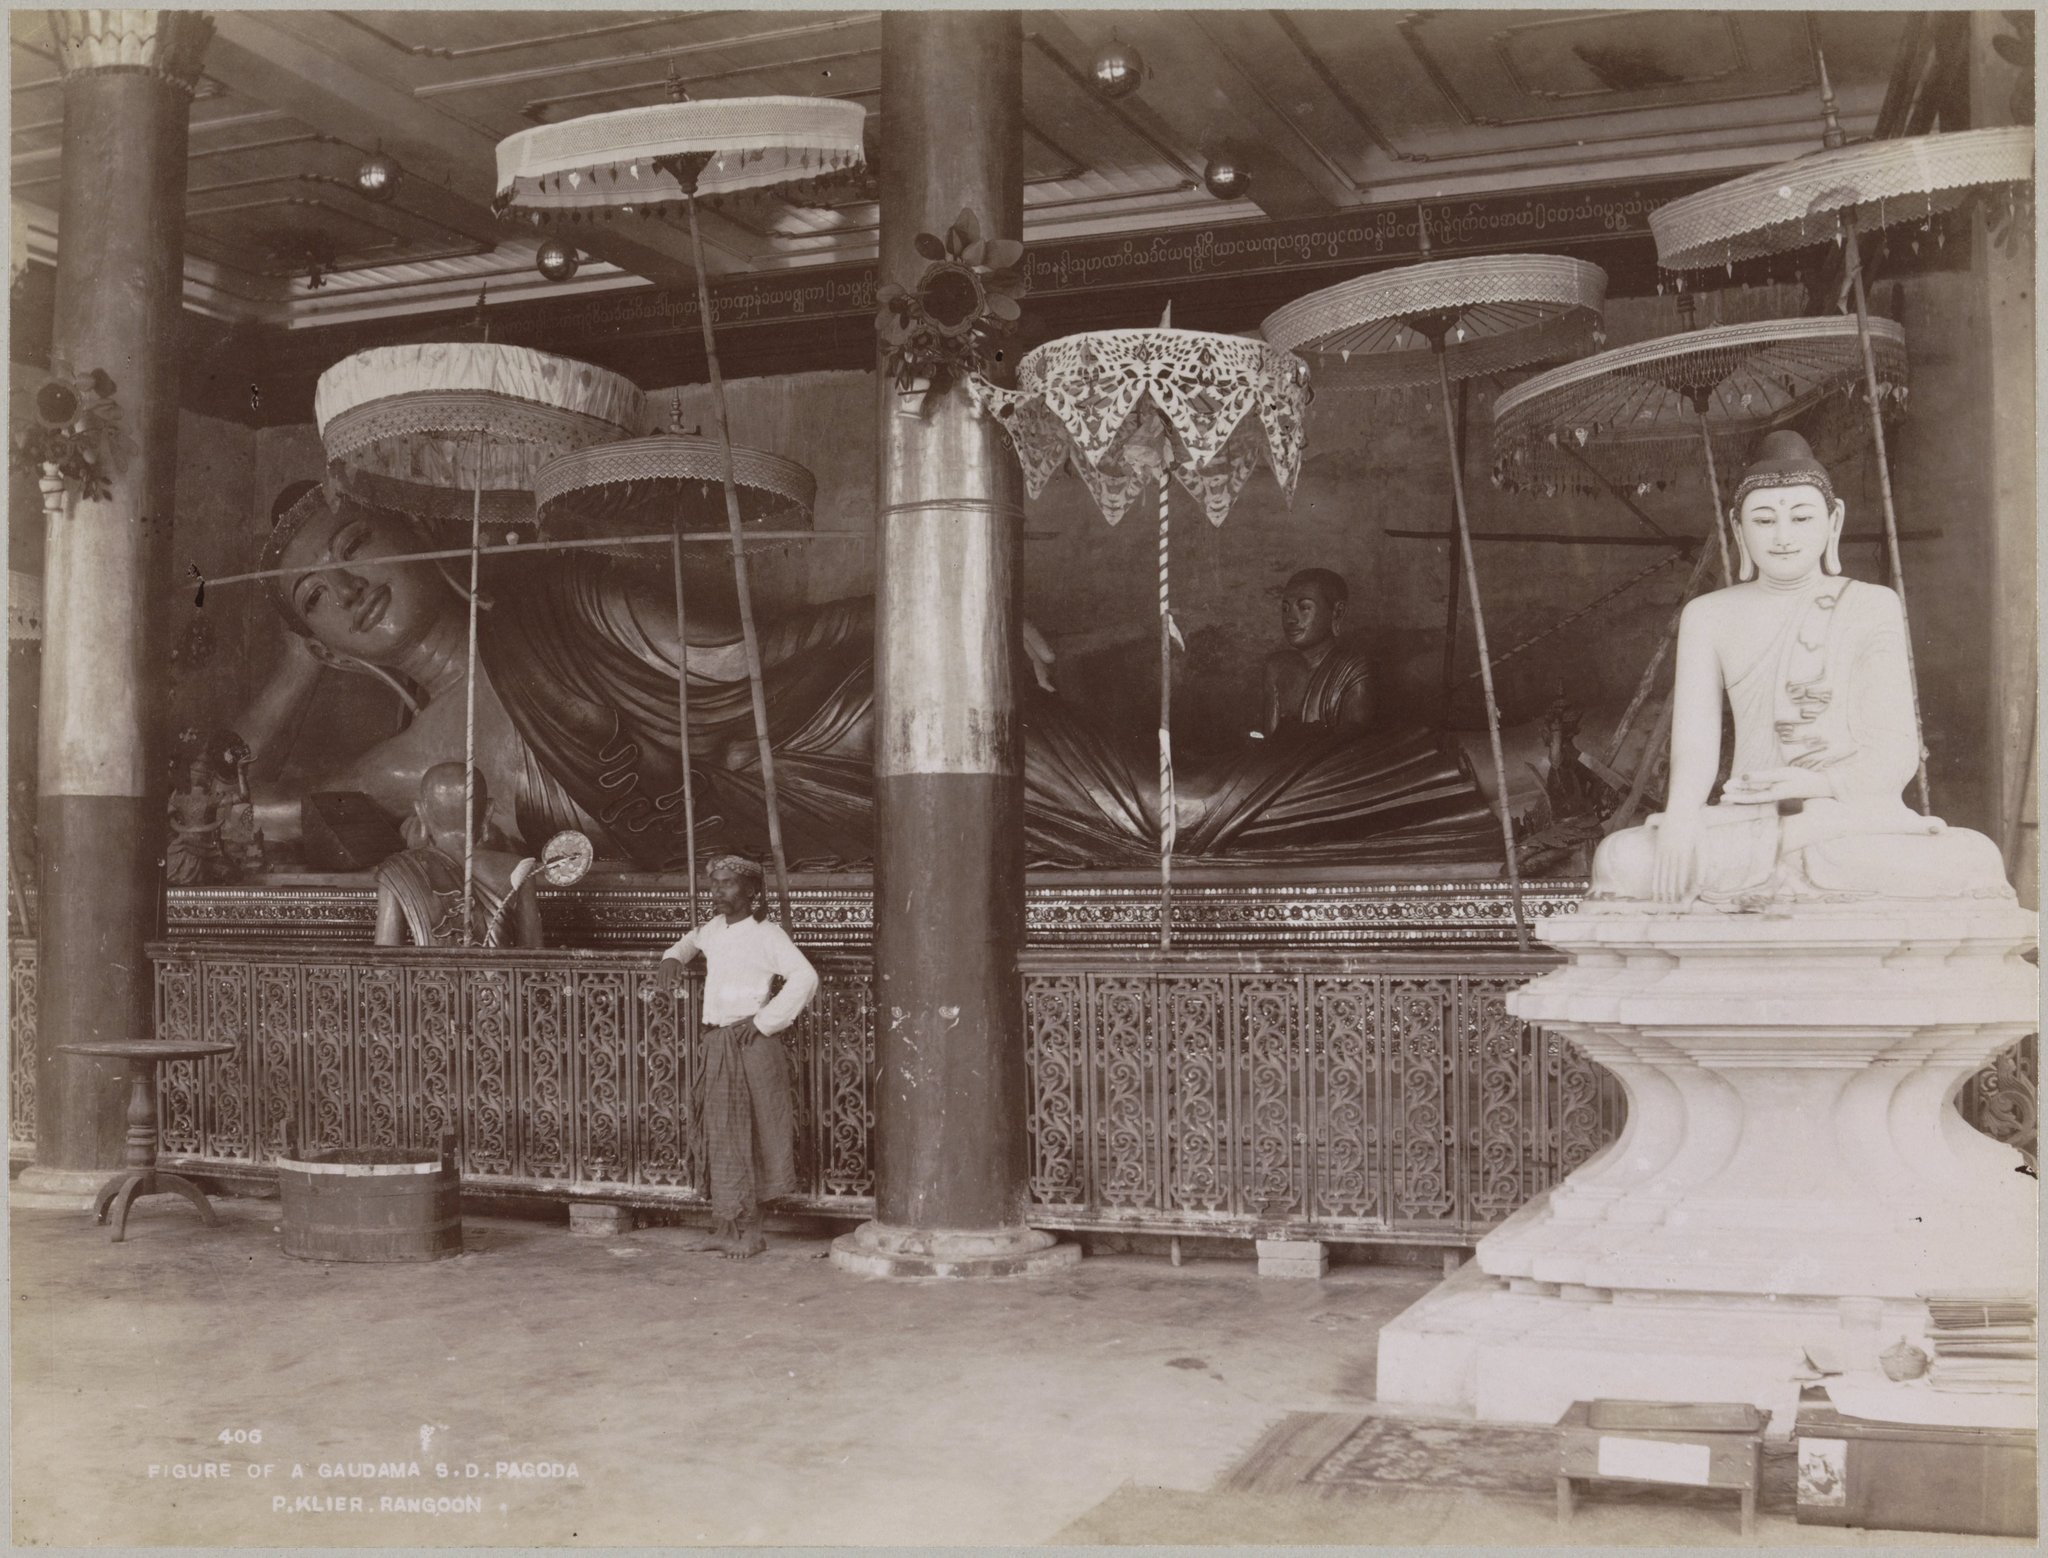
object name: photograph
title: Huge reclining Buddha at the Shwedagon pagoda, Yangon, Myanmar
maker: philip adolphe klier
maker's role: fotograaf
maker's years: 1845-1911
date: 1895-1915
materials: cardboard, paper, photographic support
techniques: albumen print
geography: yangon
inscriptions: inscription: ‘406/ Figure of A Gaudama S. D. Pagoda/ P. Klier. Rangoon.’, number: ‘7.’